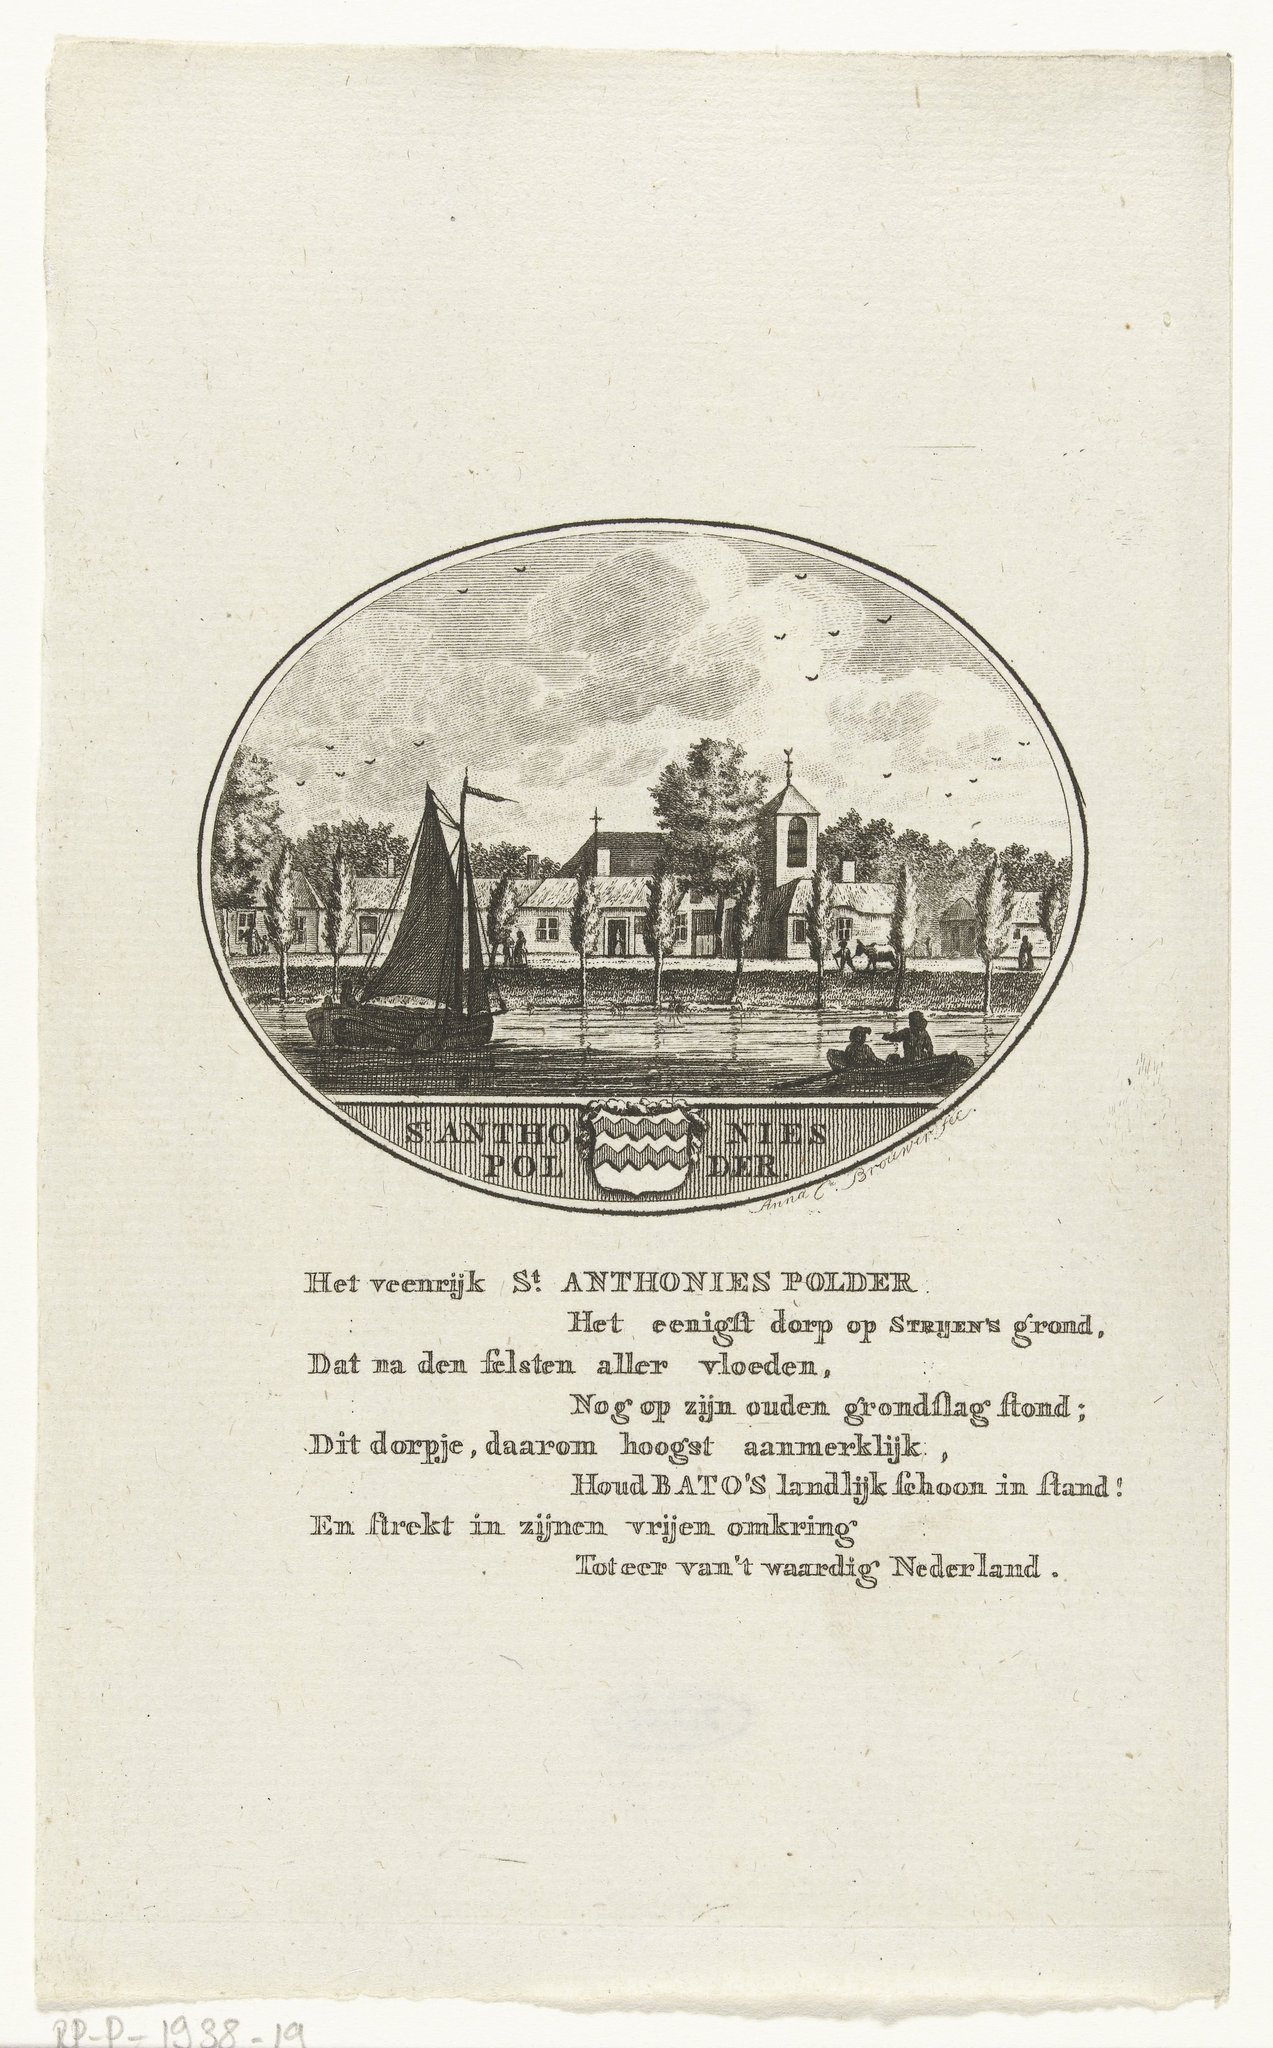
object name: book illustration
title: Gezicht op het gehucht Sint Anthoniepolder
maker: anna catharina brouwer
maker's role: print maker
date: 1791-1793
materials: paper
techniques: etching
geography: amsterdam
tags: city-view in general; 'veduta'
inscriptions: collector's mark: Lugt 2228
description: afkomstig uit: L. van Ollefen, De Nederlandsche stad- en dorpbeschrijver. Deel 1. Amsterdam: H.A. Banse, 1793